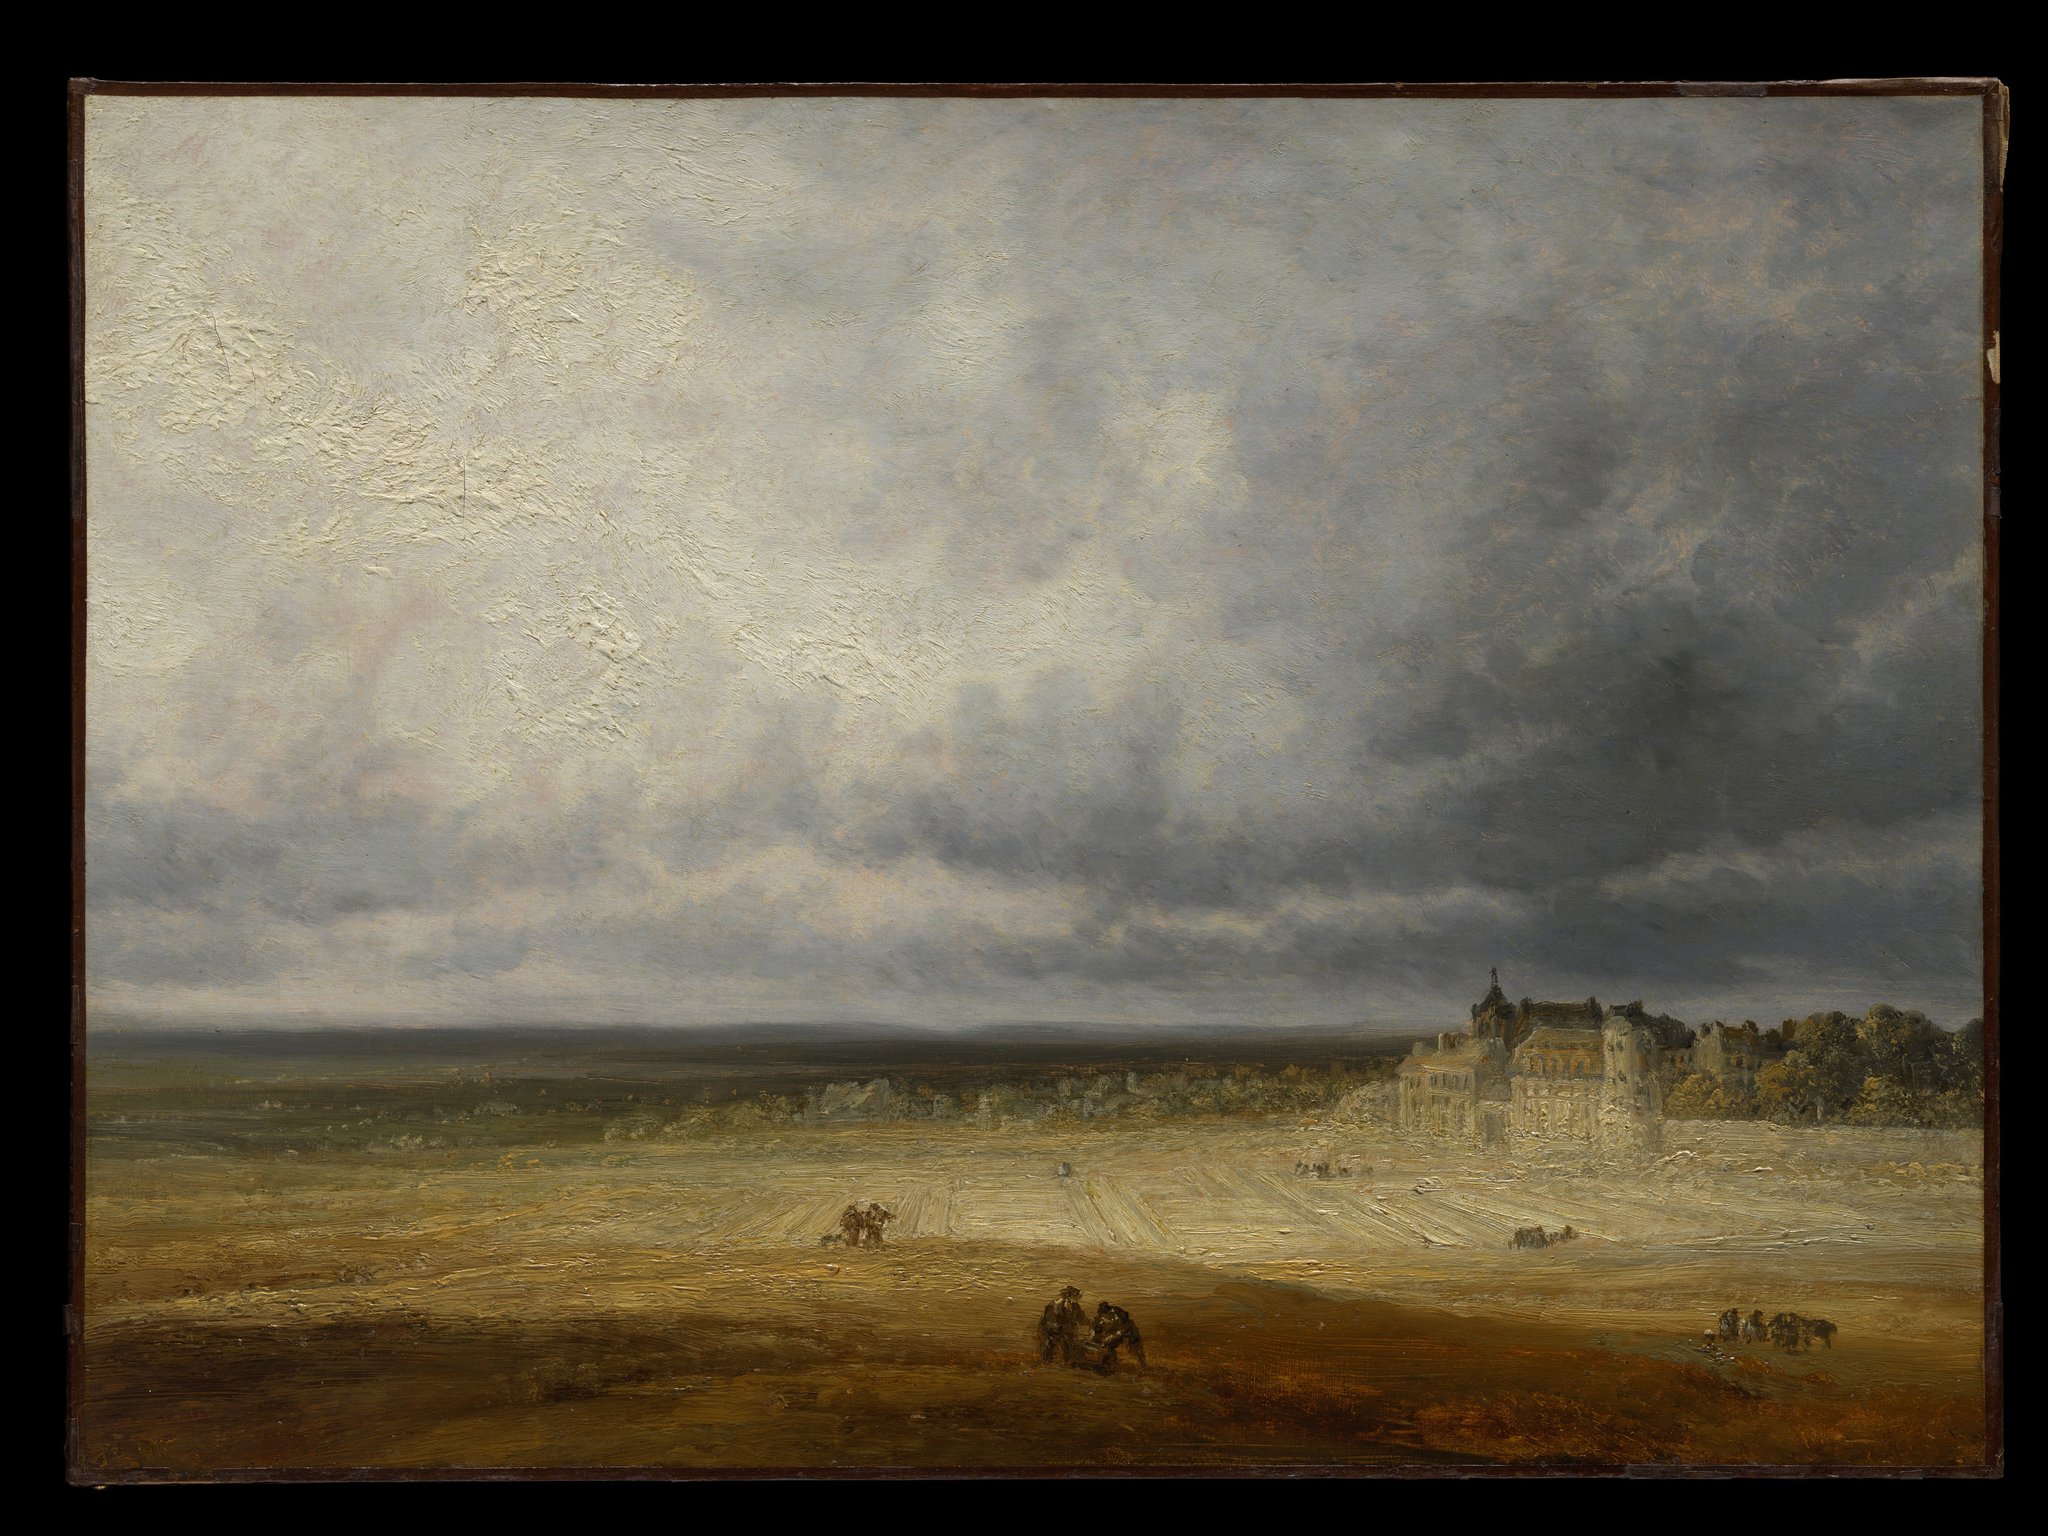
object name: painting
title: Landscape with a Plowed Field and a Village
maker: georges michel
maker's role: artist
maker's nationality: french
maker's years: 1763-1843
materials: canvas, oil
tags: landscapes